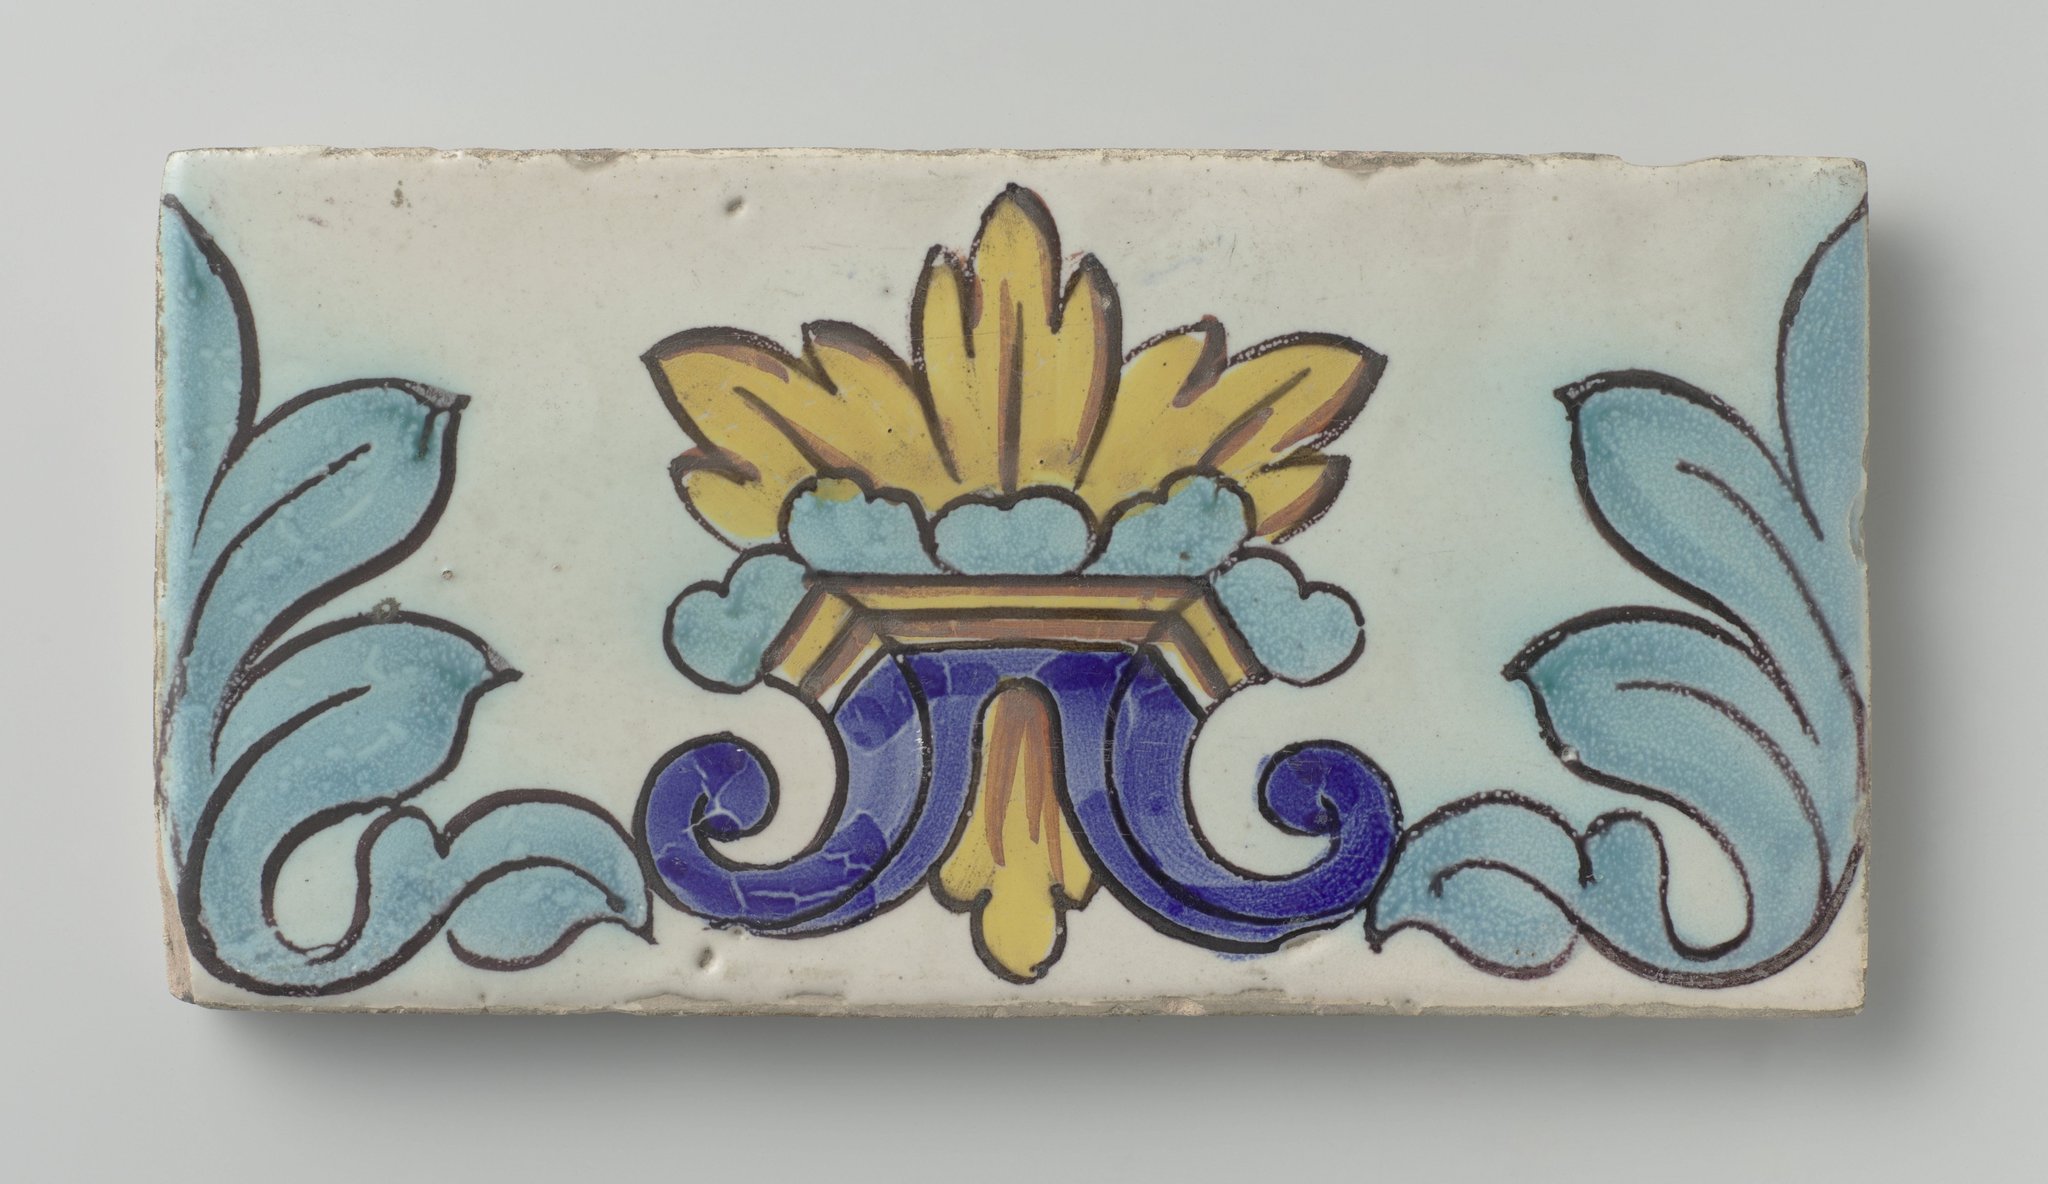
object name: randtegel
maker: Anonymous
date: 1750-1799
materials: earthenware, glaze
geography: spain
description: Randtegel (a en b vormen een doorlopend fries), beschilderd in blauw, geel, oranje, turkoois en mangaan. In het midden een console met voluten tussen twee halve palmetachtige motieven.